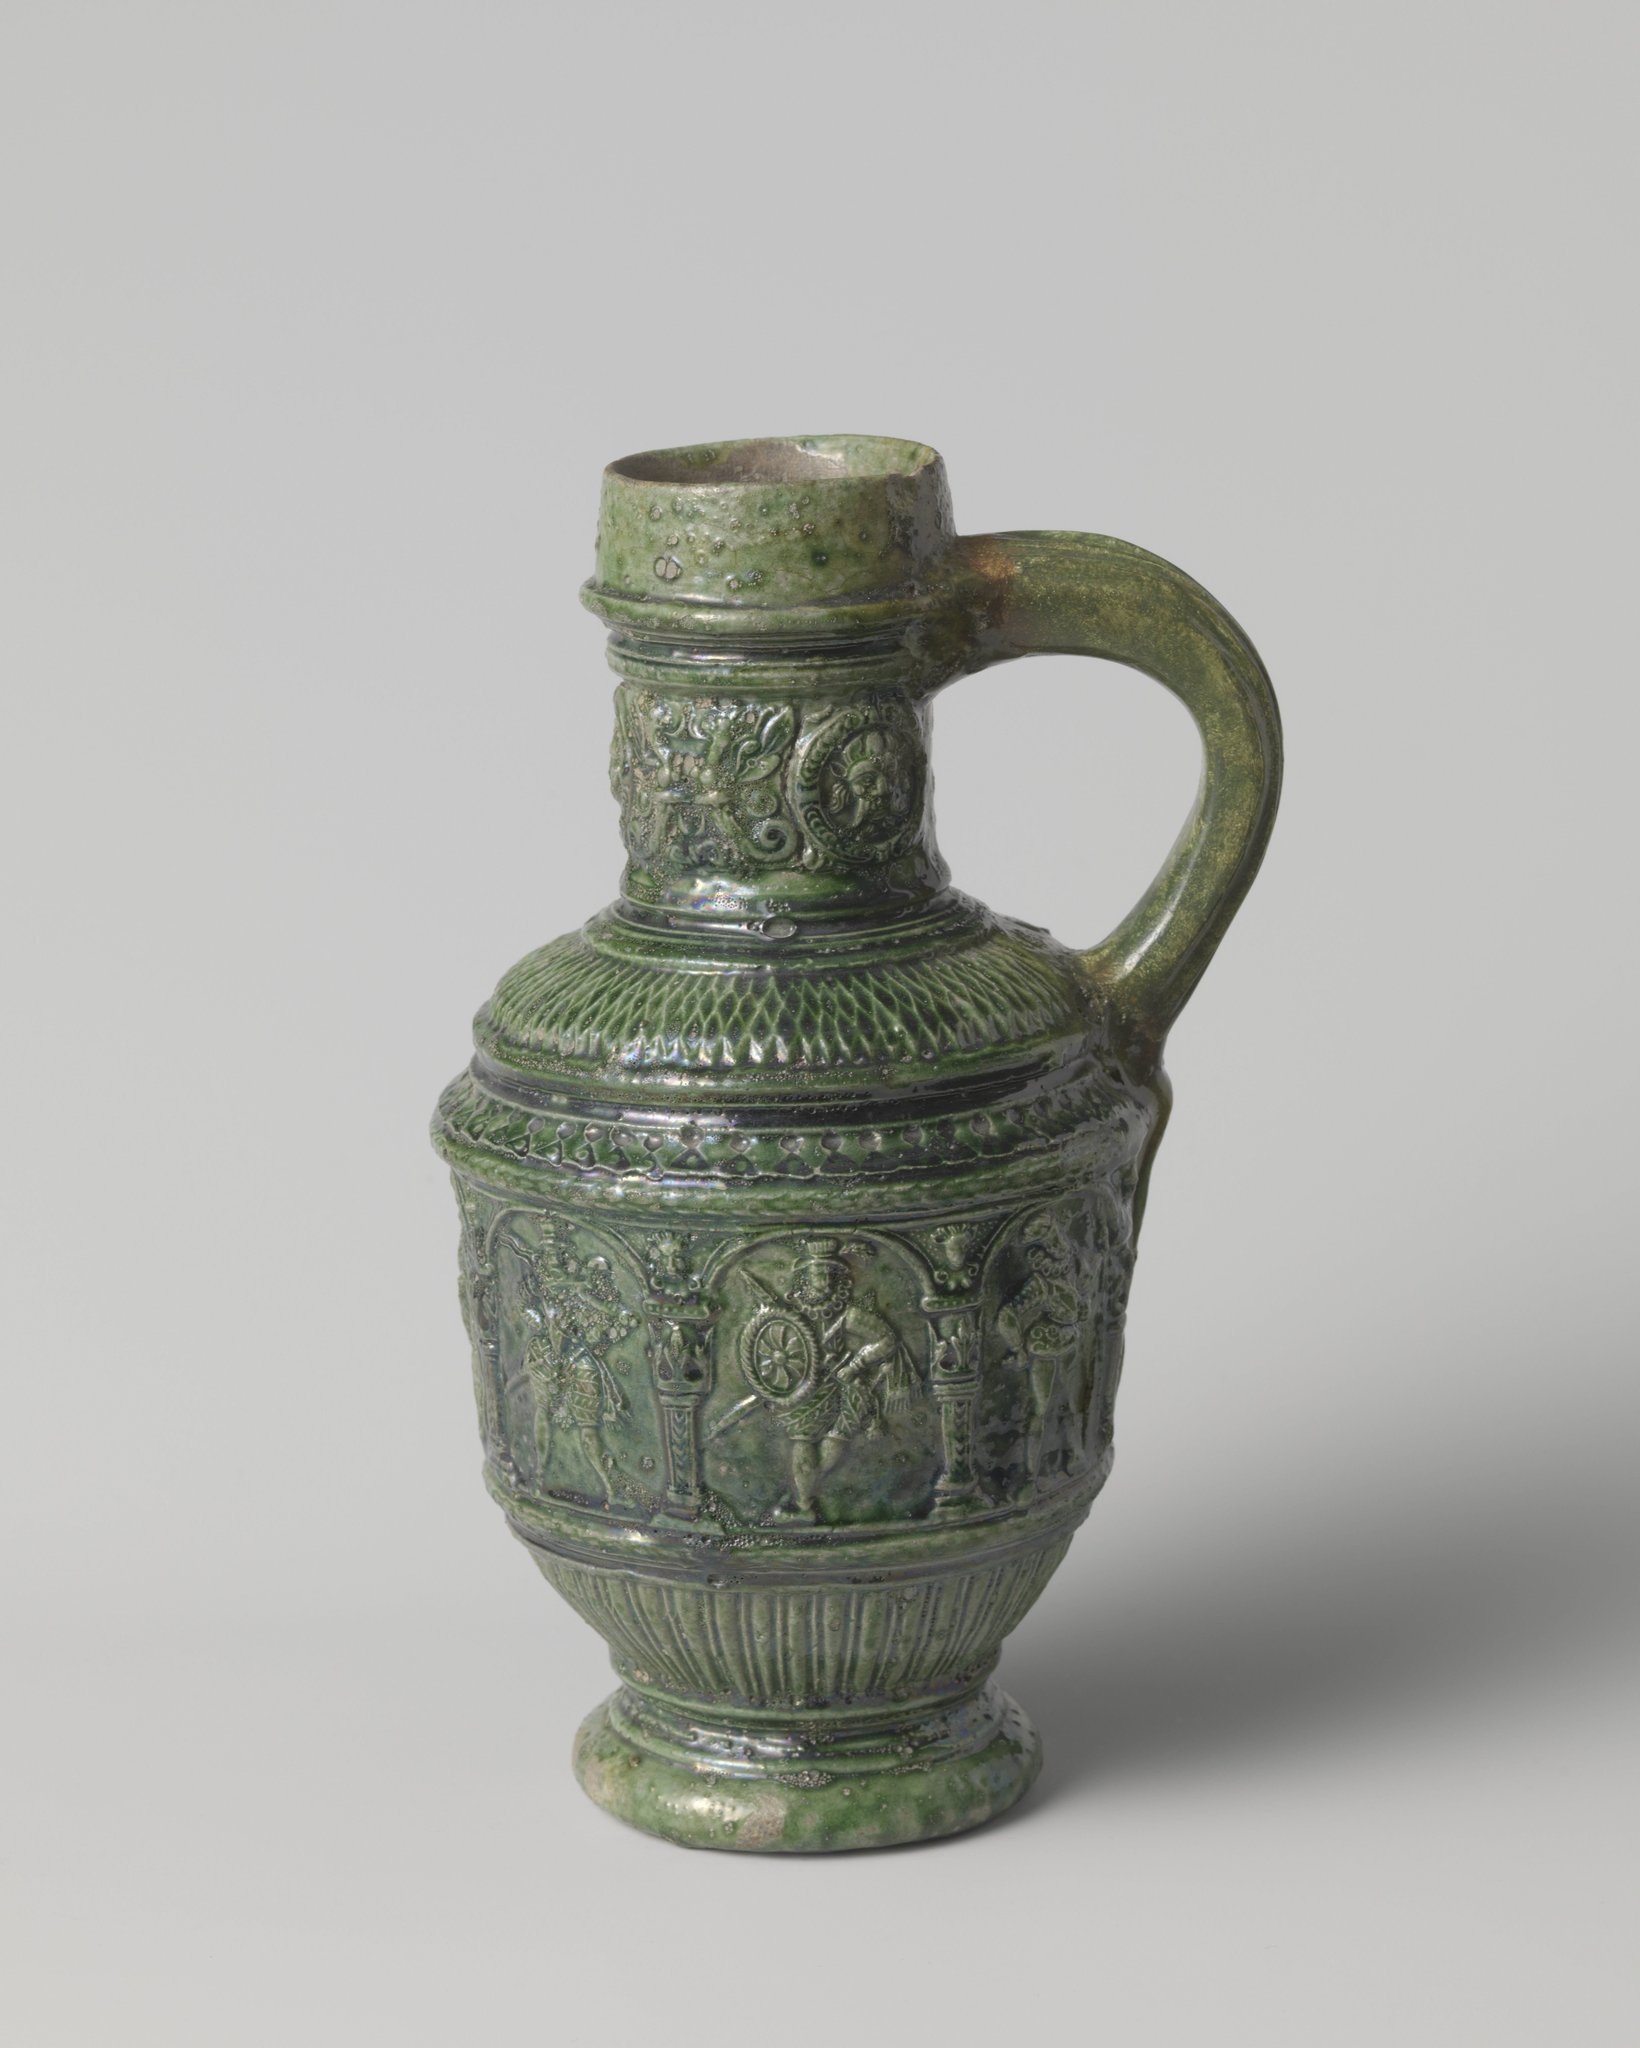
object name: jug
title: Jug with men beneath arches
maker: Anonymous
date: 1600-1624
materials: glaze, stoneware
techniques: firing, forming, relief, turning, vitrification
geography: raeren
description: Kruik van steengoed op hoge voet met een cilindrisch lichaam met ronde schouder en wijde nek. Het C-vormige oor is bevestigd aan de nek en de schouder. Profielen op de nek, buik en voet. Bedekt met een groen glazuur. Op de buik in reliëf een gedrukte en opgelegde band van mannen in 16e eeuwse kledij (krijgslieden) ten voeten uit onder bogen. Het onderste deel van de buik loopt schuin af naar de voet en heeft canelures. Op de schouder kerfsnede en een band met saterkoppen in medaillons verbonden door krulwerk in de vorm van fabeldieren op de nek. Keulen/ Raeren.